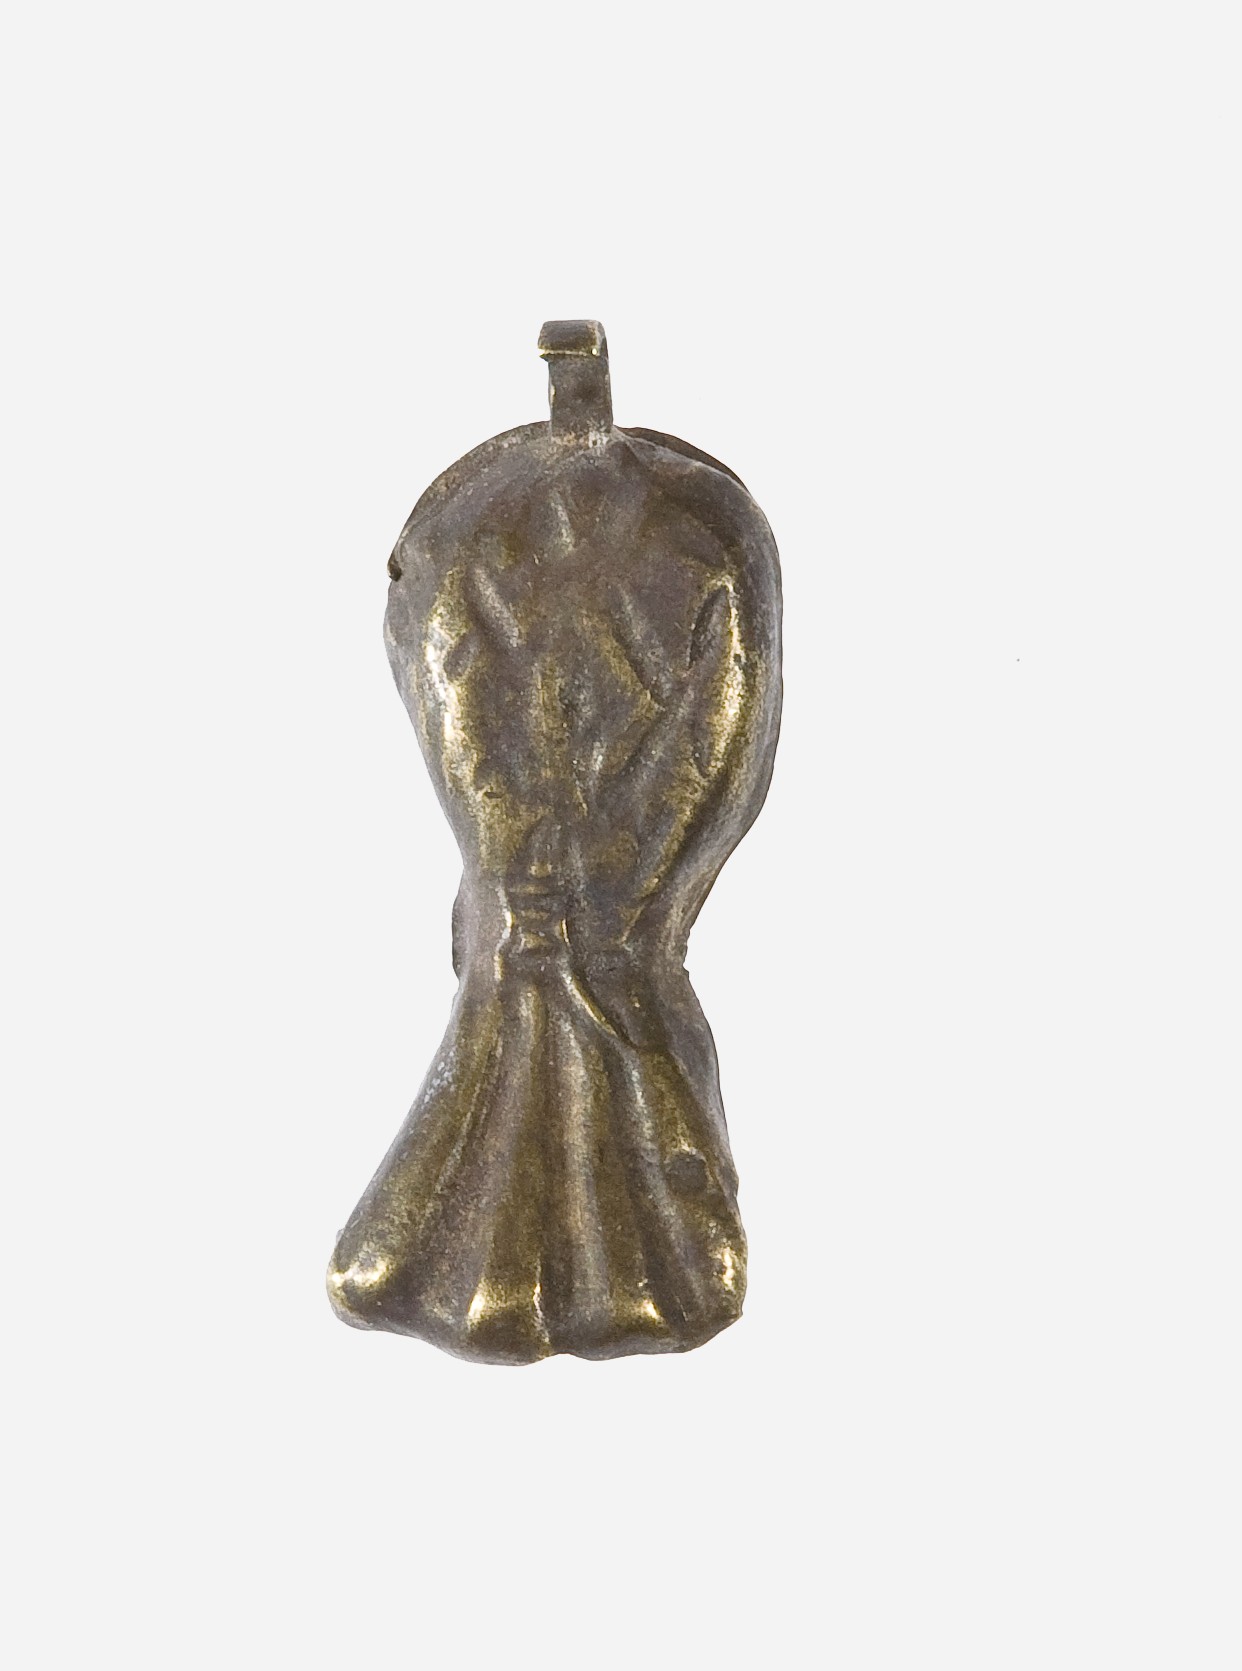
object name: pendant, cornflower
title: Cornflower Pendant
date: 1390-1352 BCE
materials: faience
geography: egypt